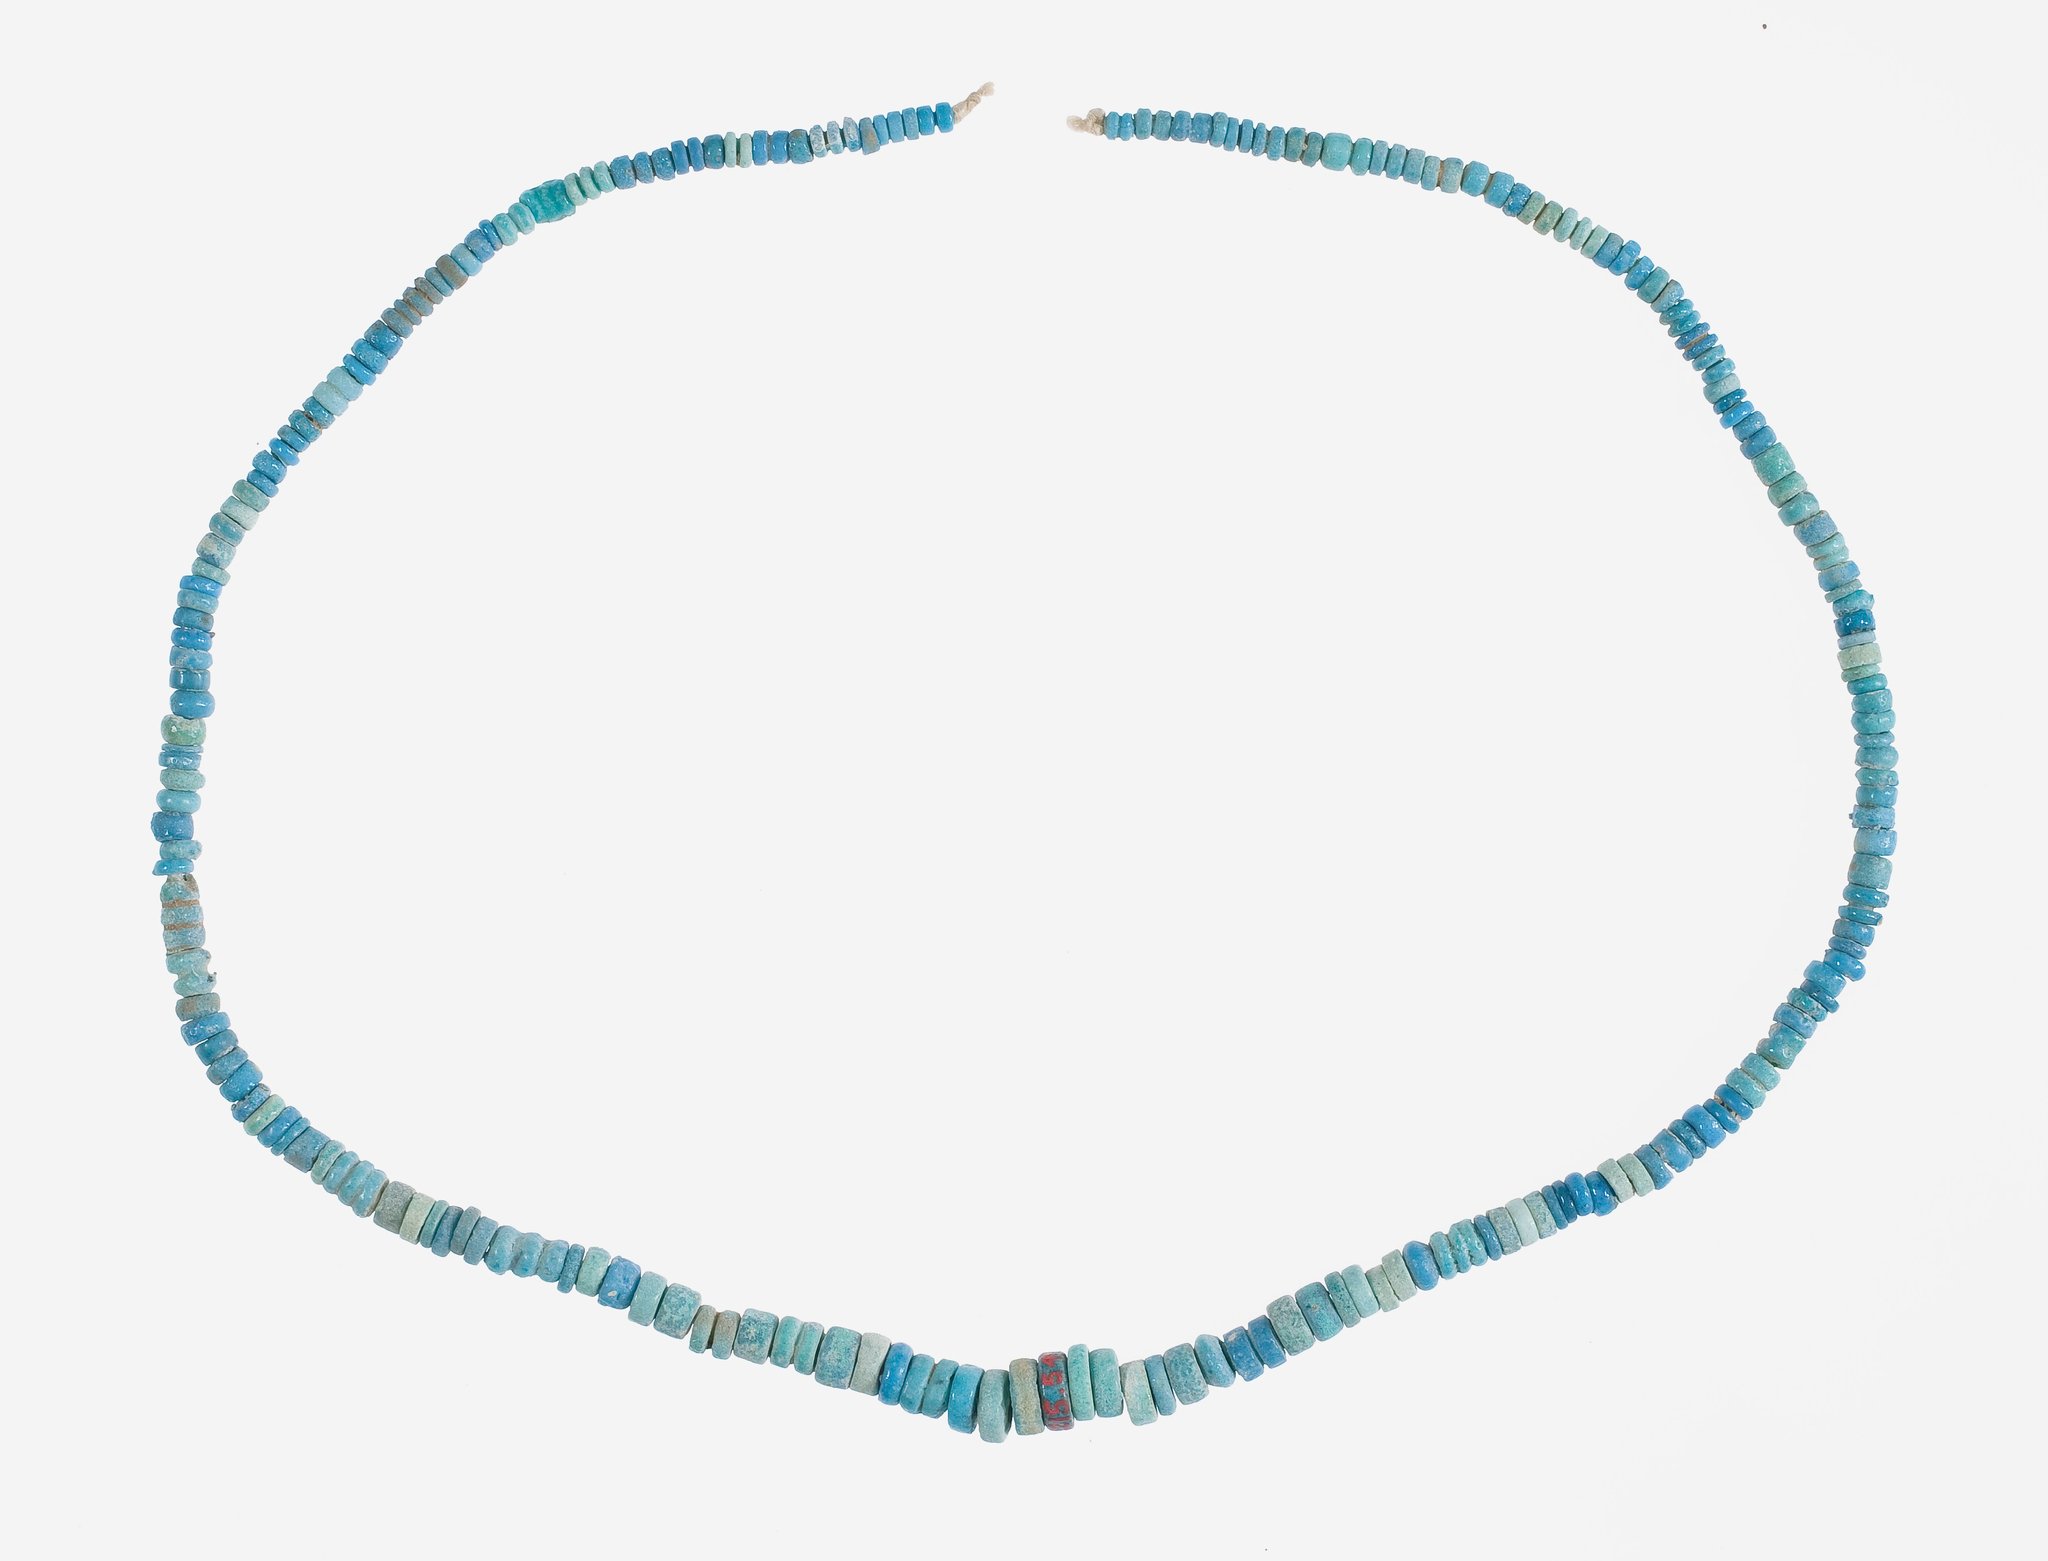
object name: bead, disk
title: String of Small Disk Beads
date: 1390-1352 BCE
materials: faience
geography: egypt